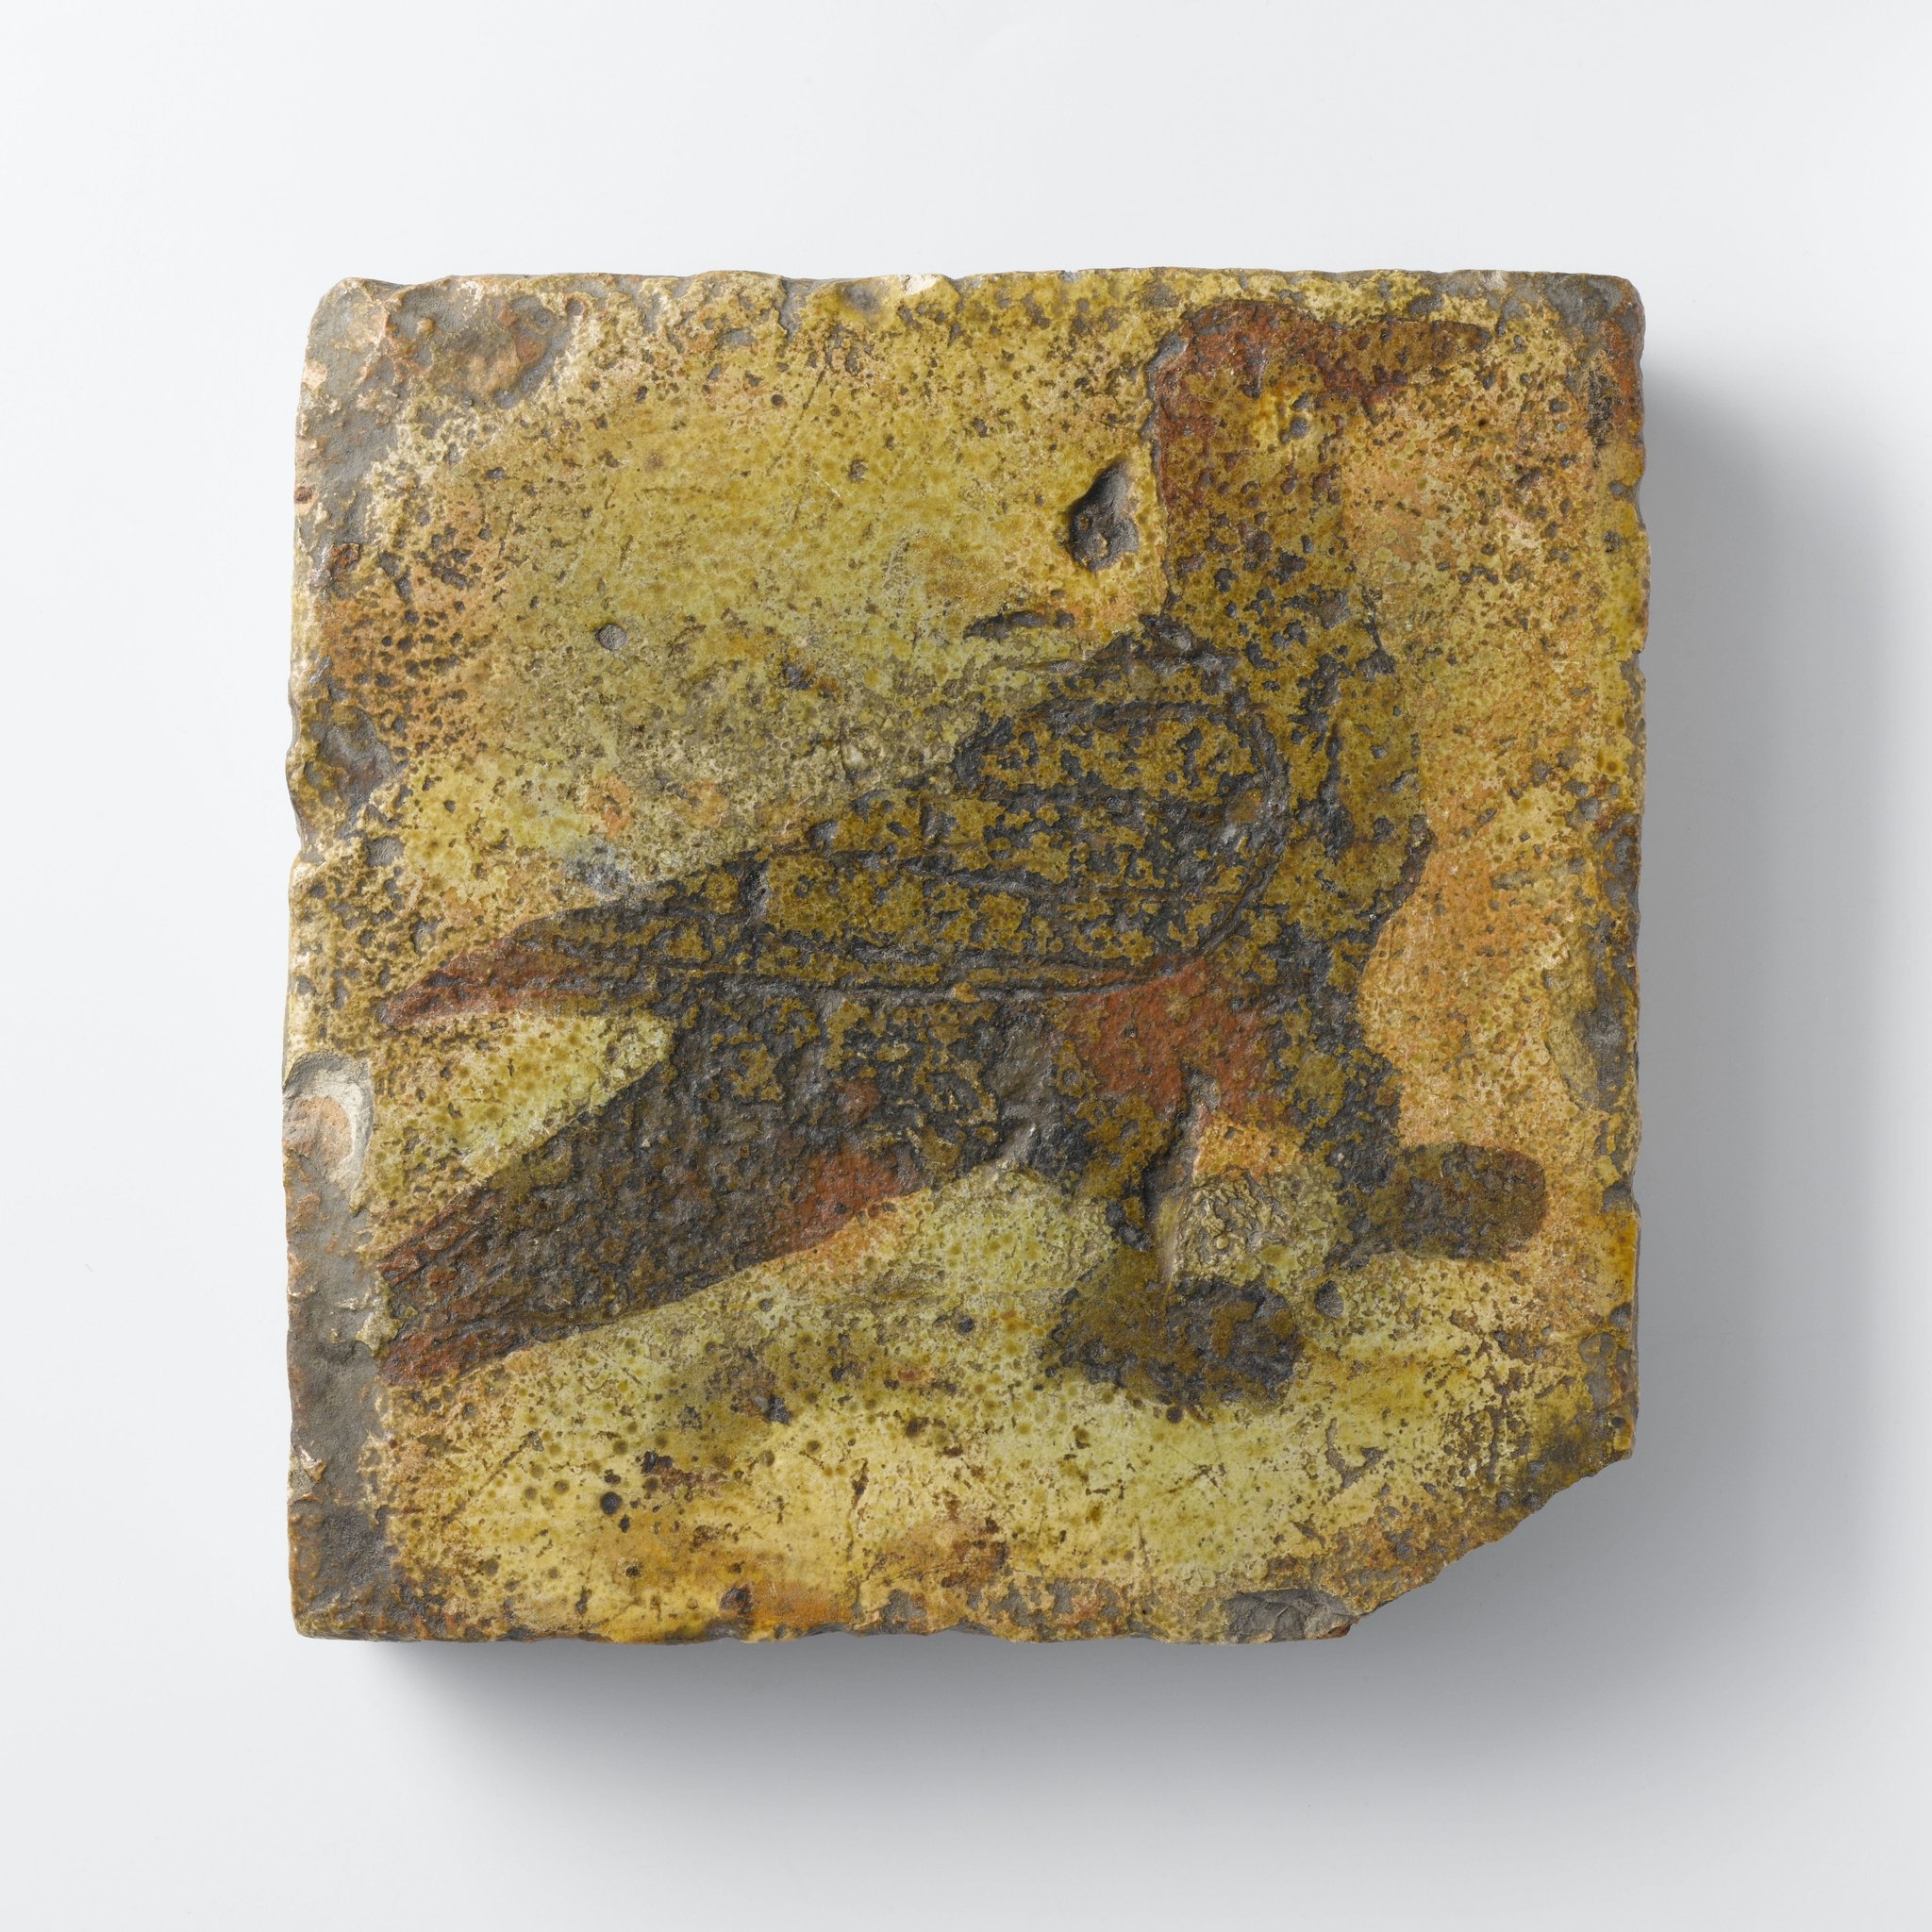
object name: tile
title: Vloertegel versierd met een vogel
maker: Anonymous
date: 1299-1499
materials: earthenware, glaze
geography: france